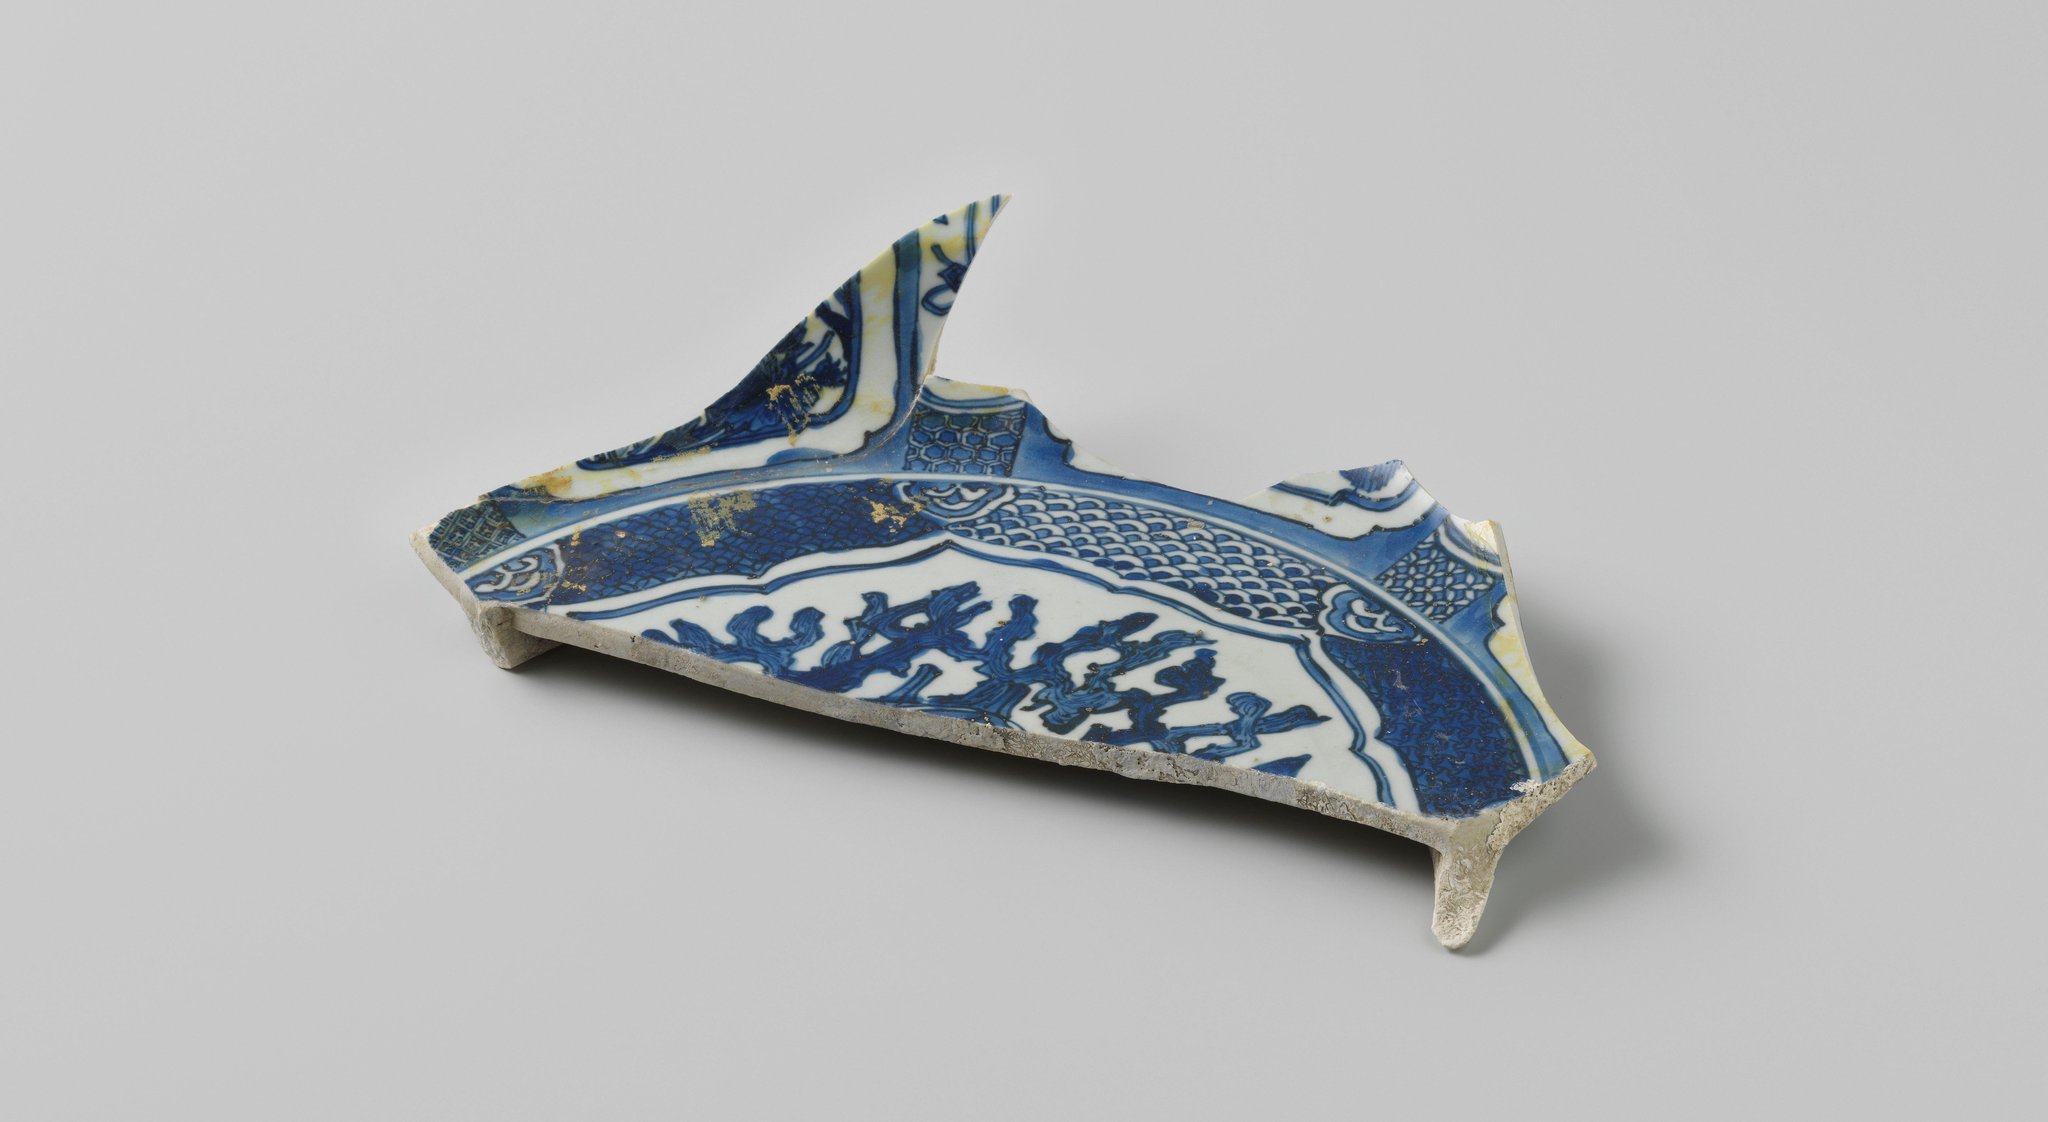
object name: sherd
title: Fragment bord uit V.O.C.-schip de 'Witte Leeuw'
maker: Anonymous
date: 1613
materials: bone china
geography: jingdezhen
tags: verenigde oostindische compagnie, sint-helena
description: Fragment bord uit V.O.C.-schip de 'Witte Leeuw'.